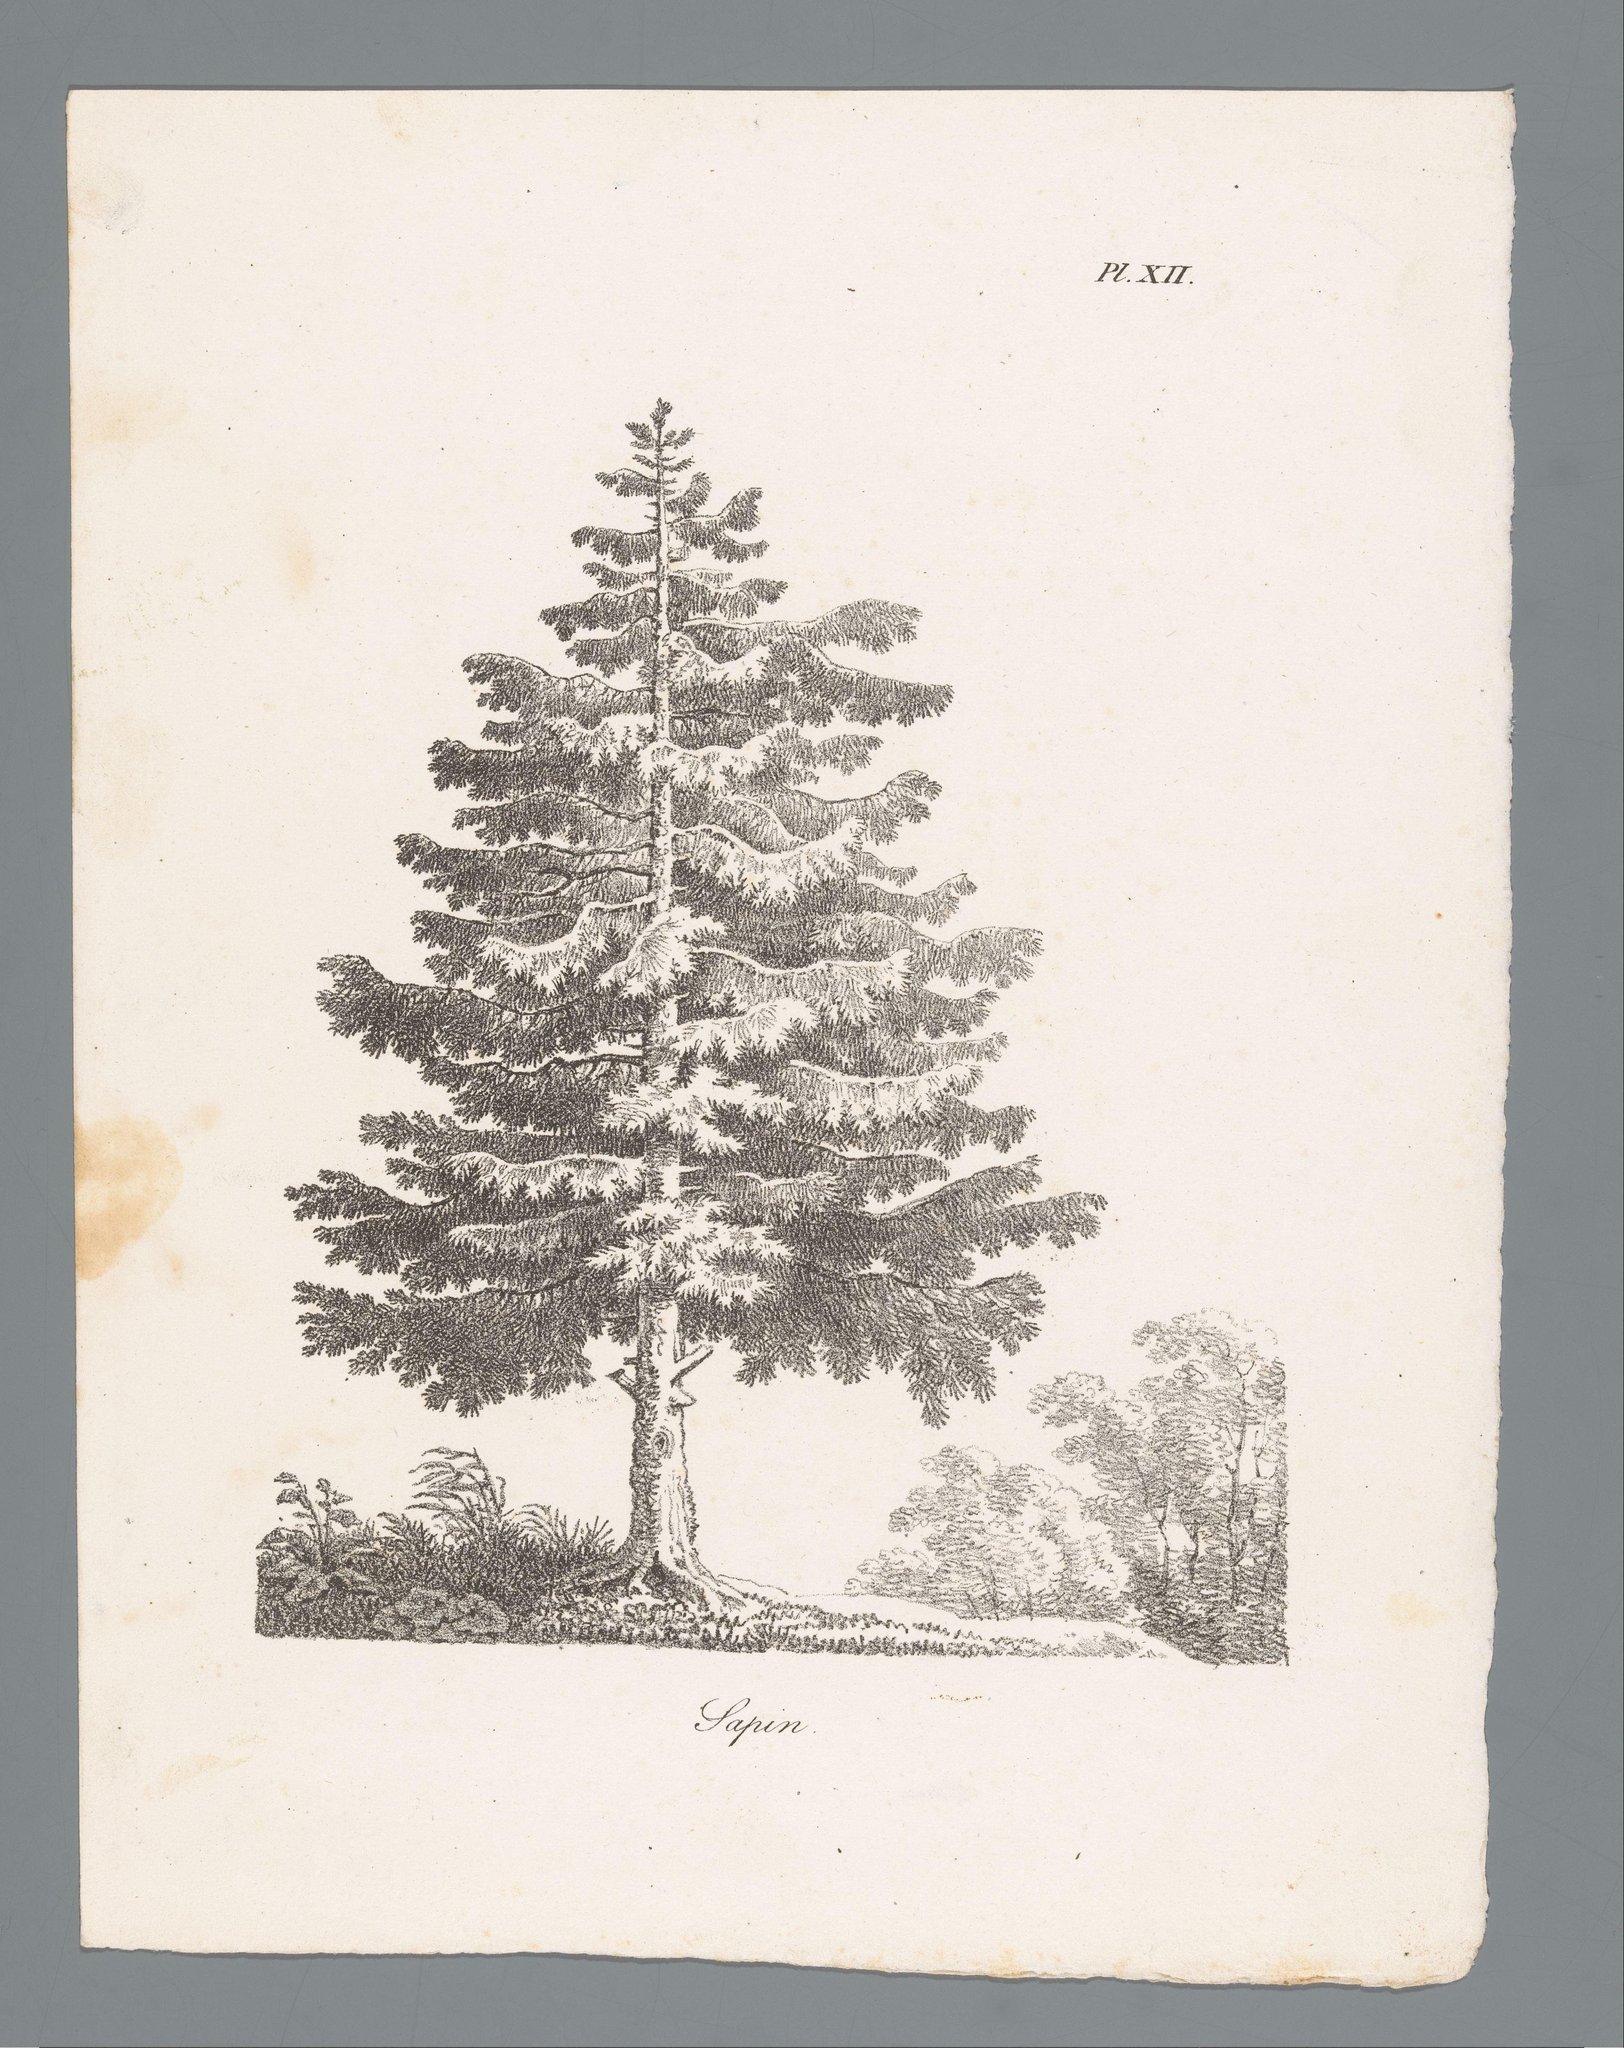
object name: print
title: Sapin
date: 1820-1833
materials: paper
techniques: lithograph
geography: mulhouse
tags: trees: fir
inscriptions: collector's mark: Lugt 2228